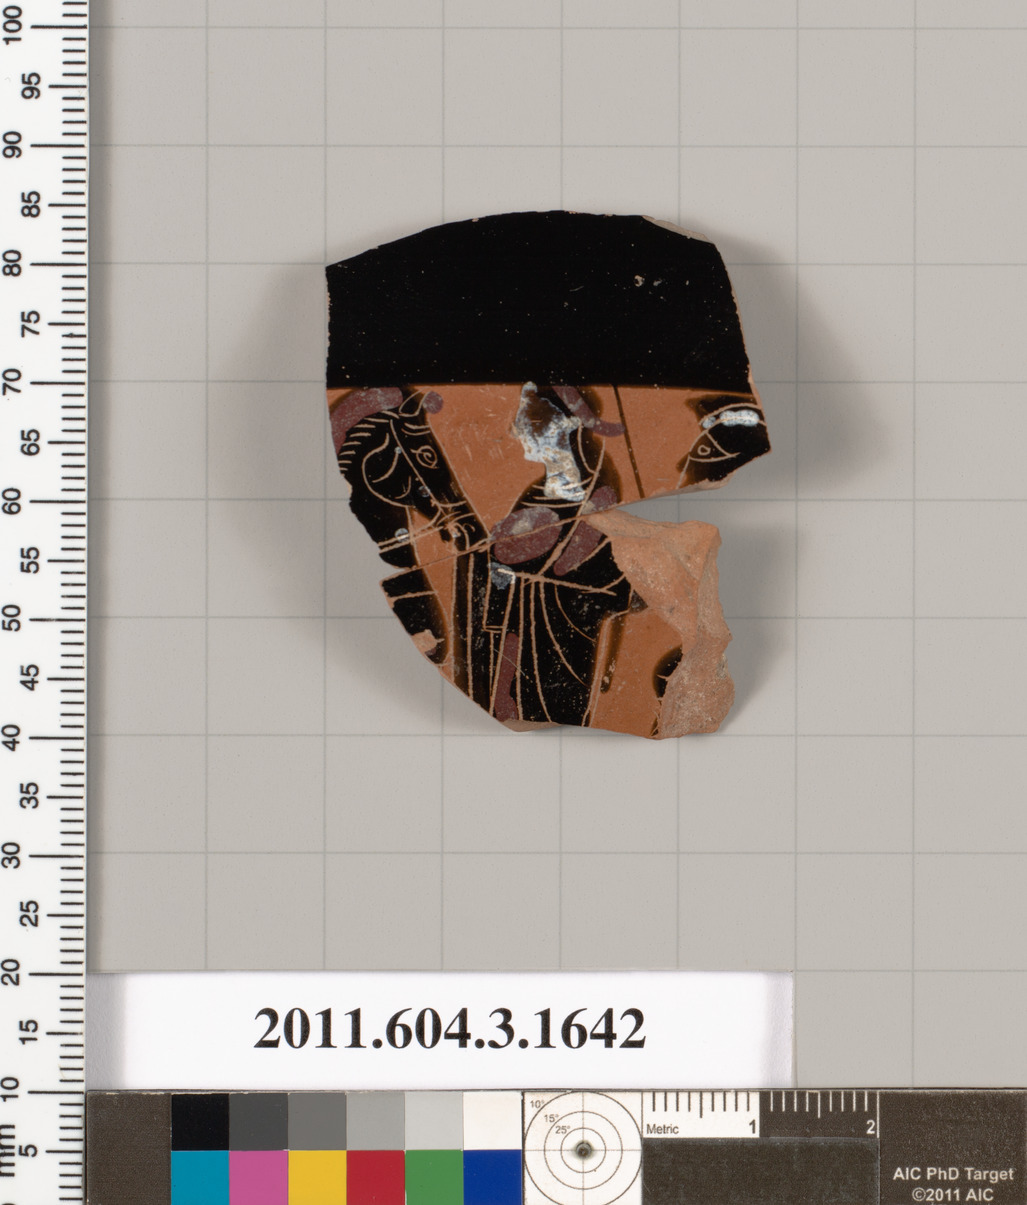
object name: kylix fragment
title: Terracotta fragment of a kylix: Band cup (drinking cup)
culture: greek, attic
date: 567-535 BCE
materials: terracotta